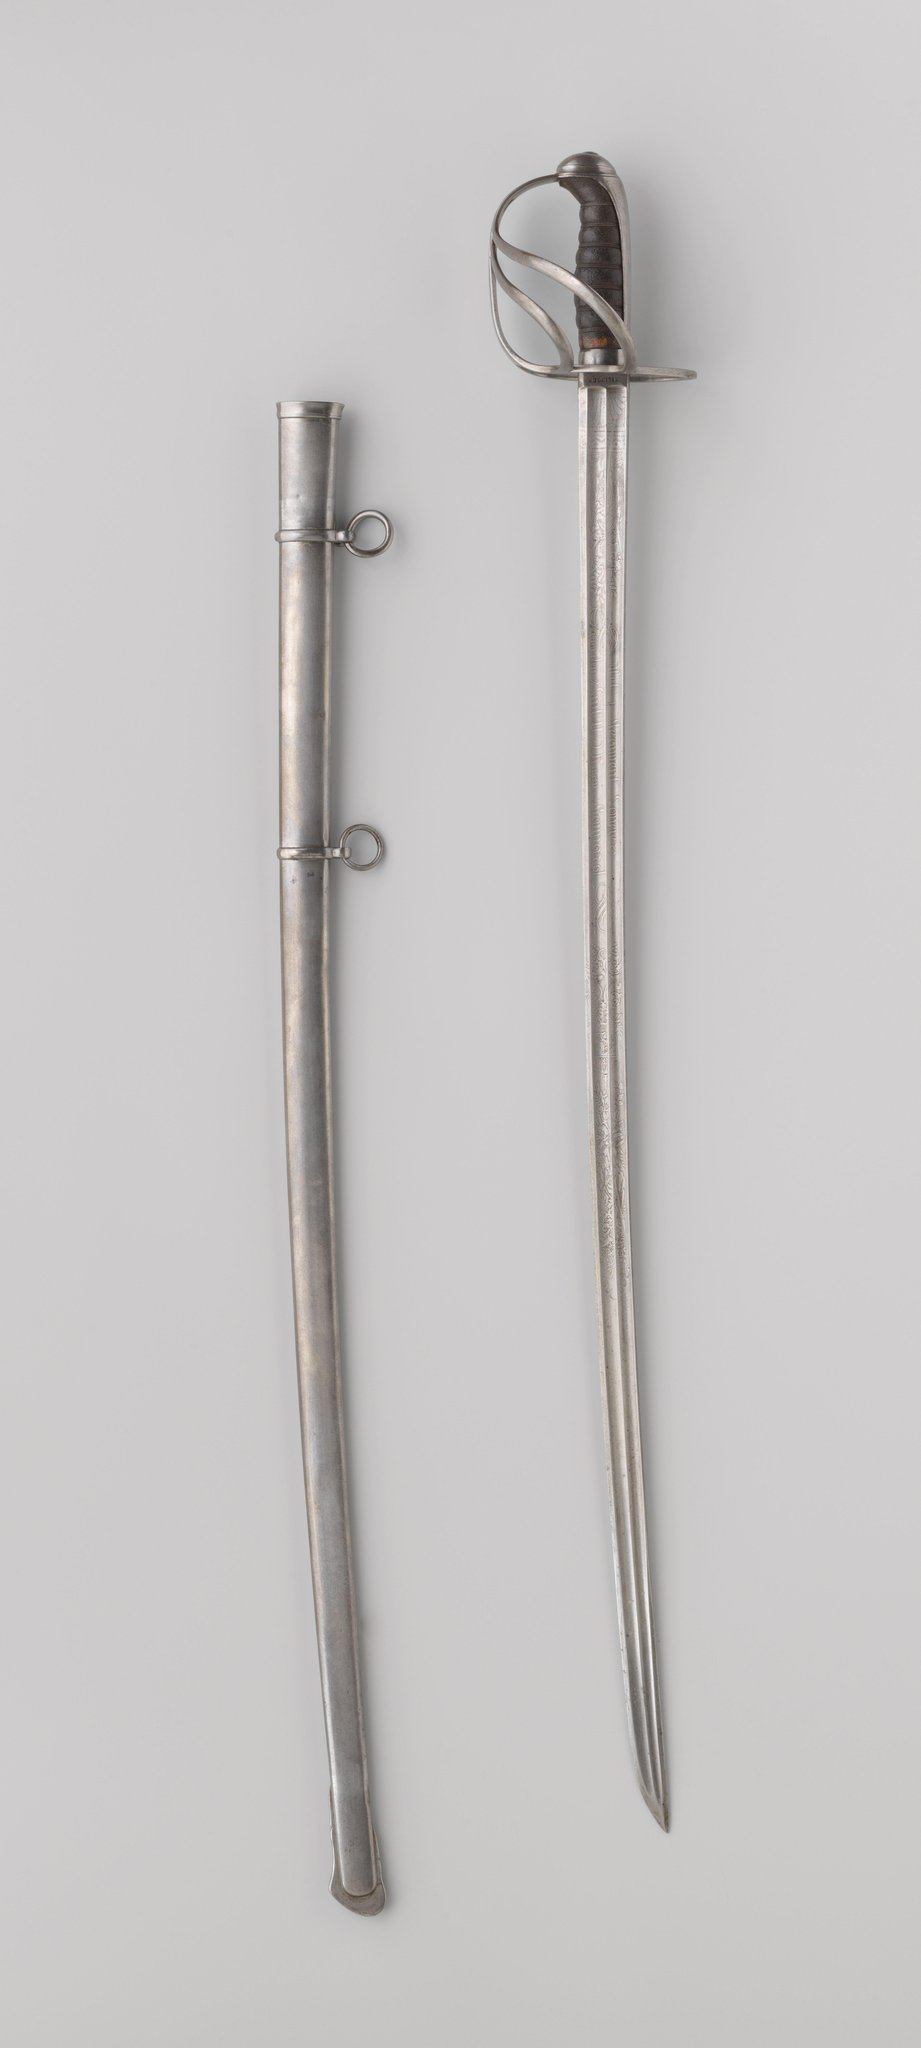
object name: sabre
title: Officierssabel lichte cavalerie model nr. 4 met schede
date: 1843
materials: iron, steel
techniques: etching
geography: solingen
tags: netherlands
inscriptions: : ‘Het 1e Regt Lanciers aan den 2e Luit. W.C.H. van Rappard / Als vereerend blijk van van goedkeuring voor gegeven militair onderwijs 1843 op 1844’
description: Officierssabel lichte cavalerie model nr. 4. Inscriptie op de kling: Het 1e Regiment lansiers aan den 2e Lt. U.J.K. van Rappard - Als vereerende blijk van Goedkeuring voor gegeven Militair Onderwijs 1843 op. 44 - 6 december 1844. Rondom tekst gegraveerd lofwerk. En fabrieksmerk Schnitzler & Kirschbaum, Solingen. De kling van deze is zeer licht gebogen en heeft aan beide zijden dubbele geulen. De schede heeft 2 ringen, waarvan de bovenste (1859) vast zit.